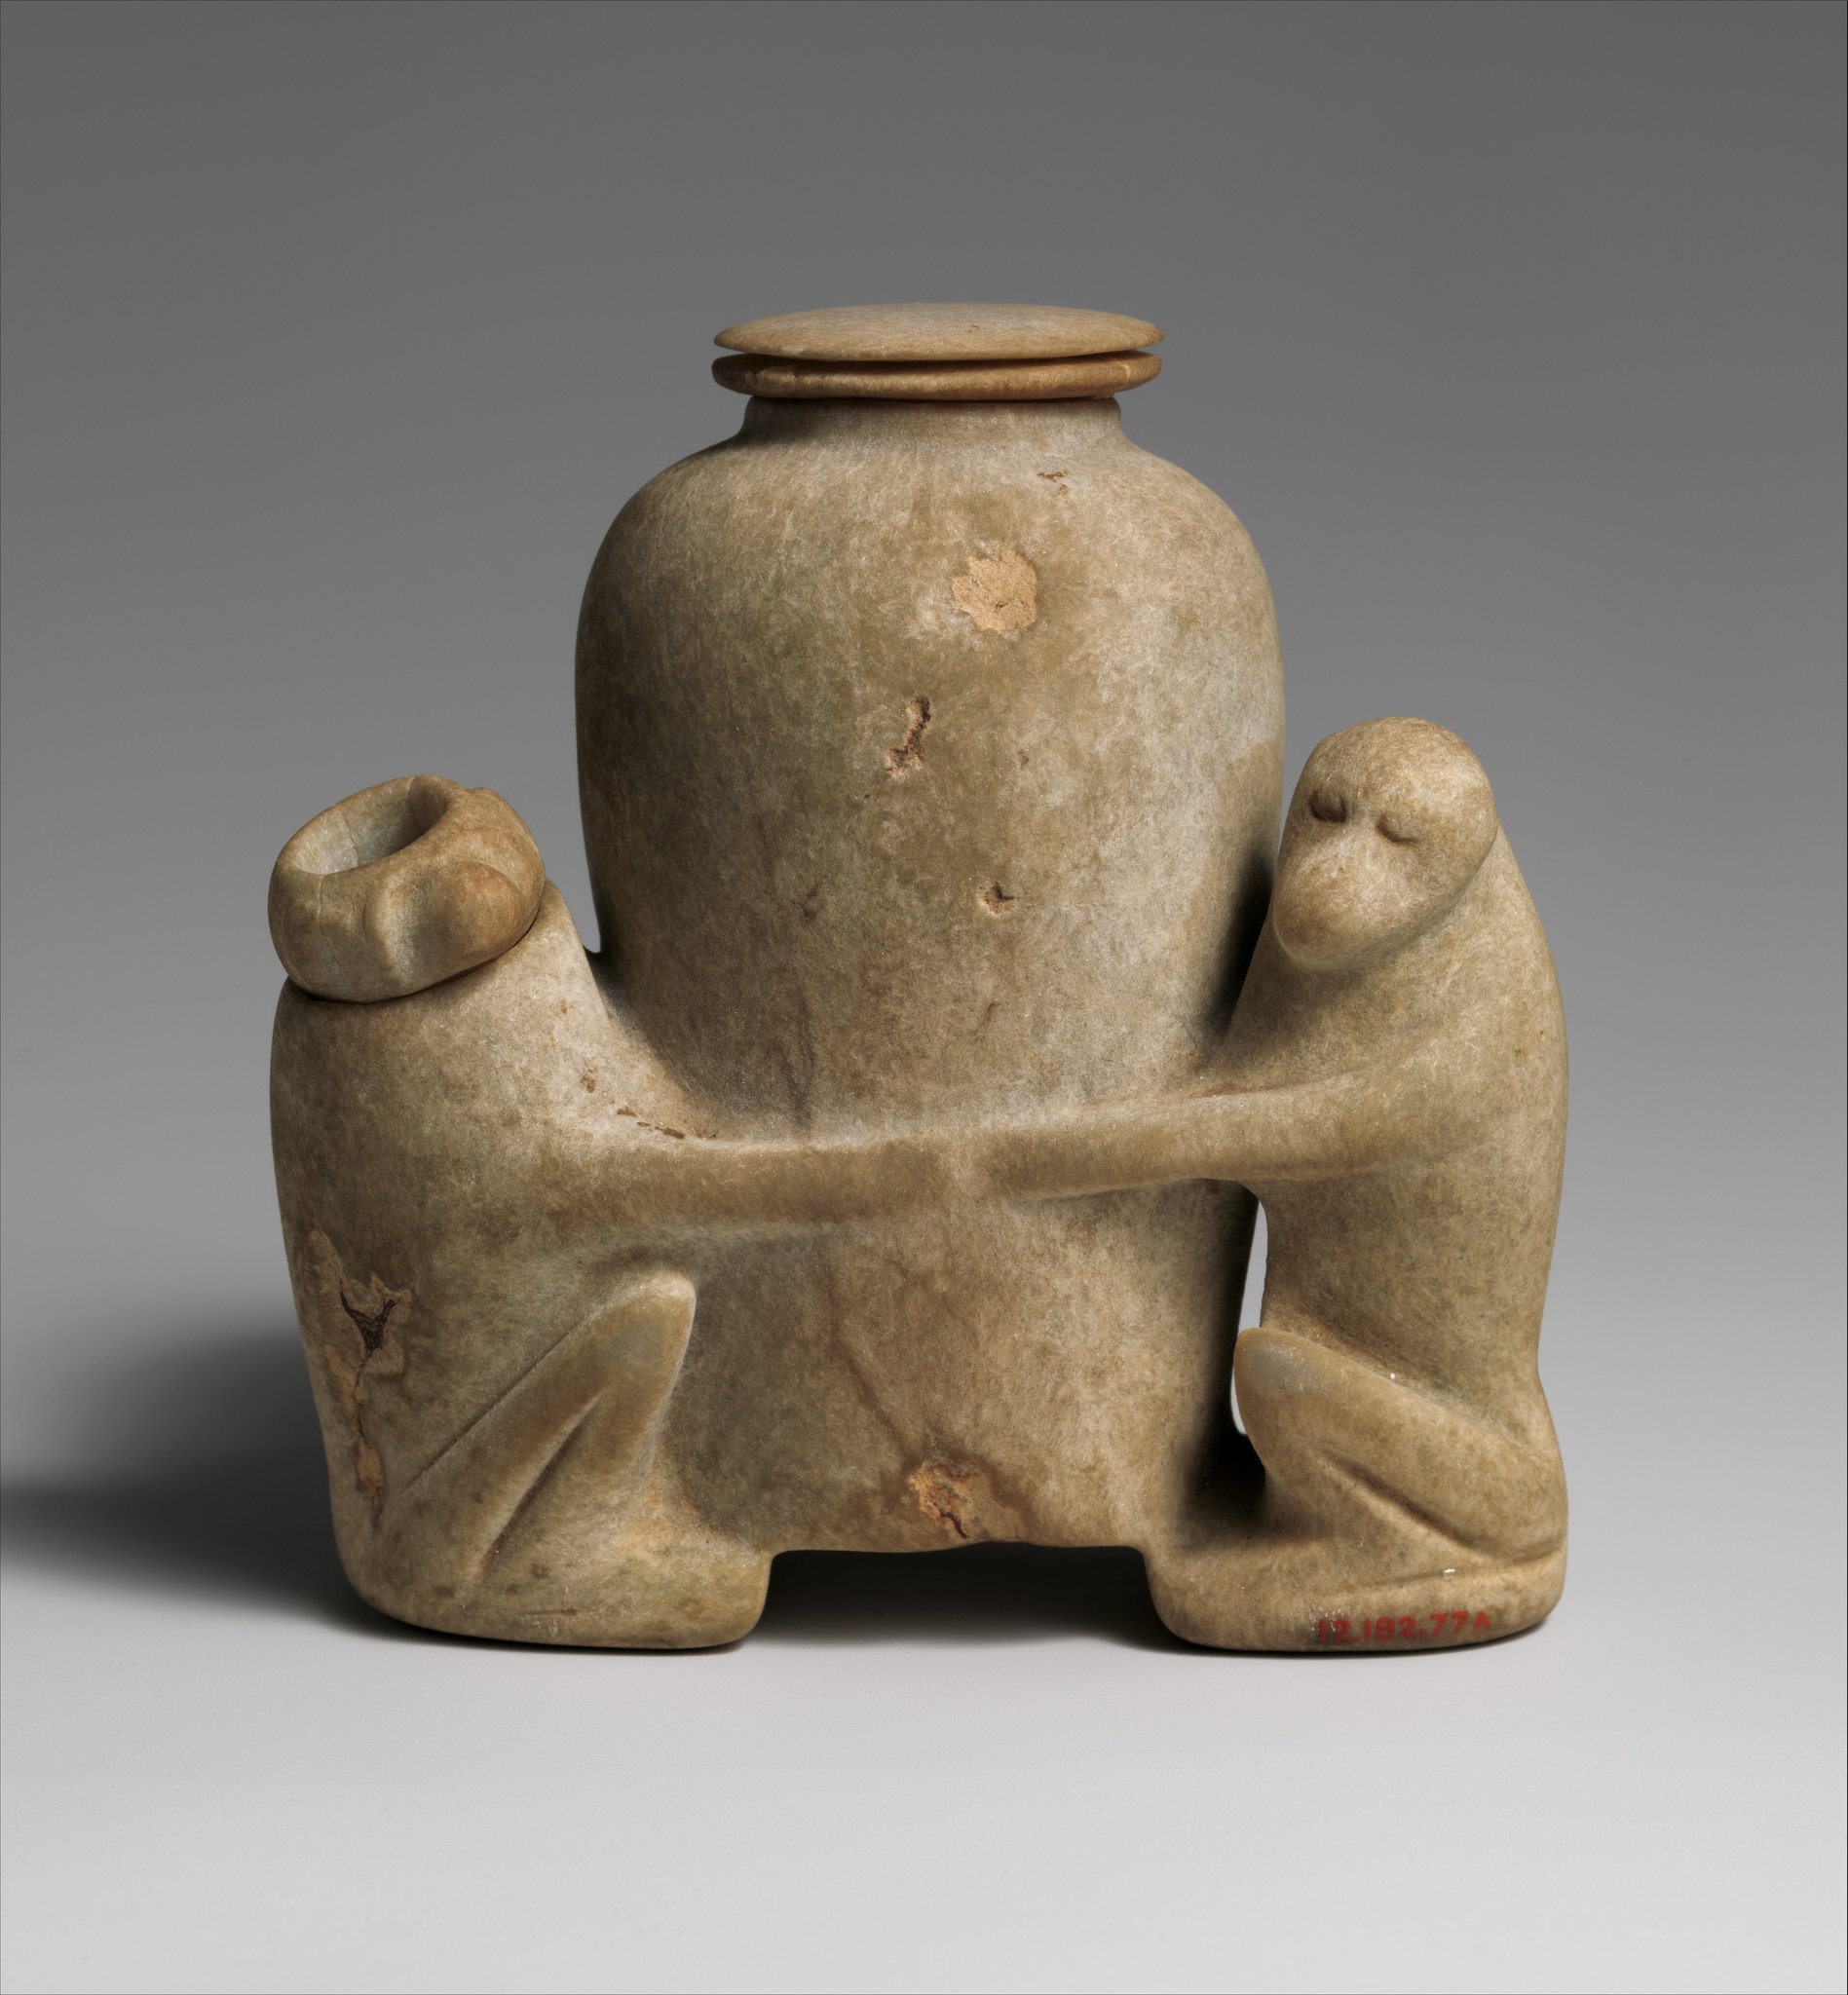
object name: ointment jar, baboon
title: Ointment vessel in the shape of two baboons holding a jar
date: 1800-1550 BCE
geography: northern upper egypt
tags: animals